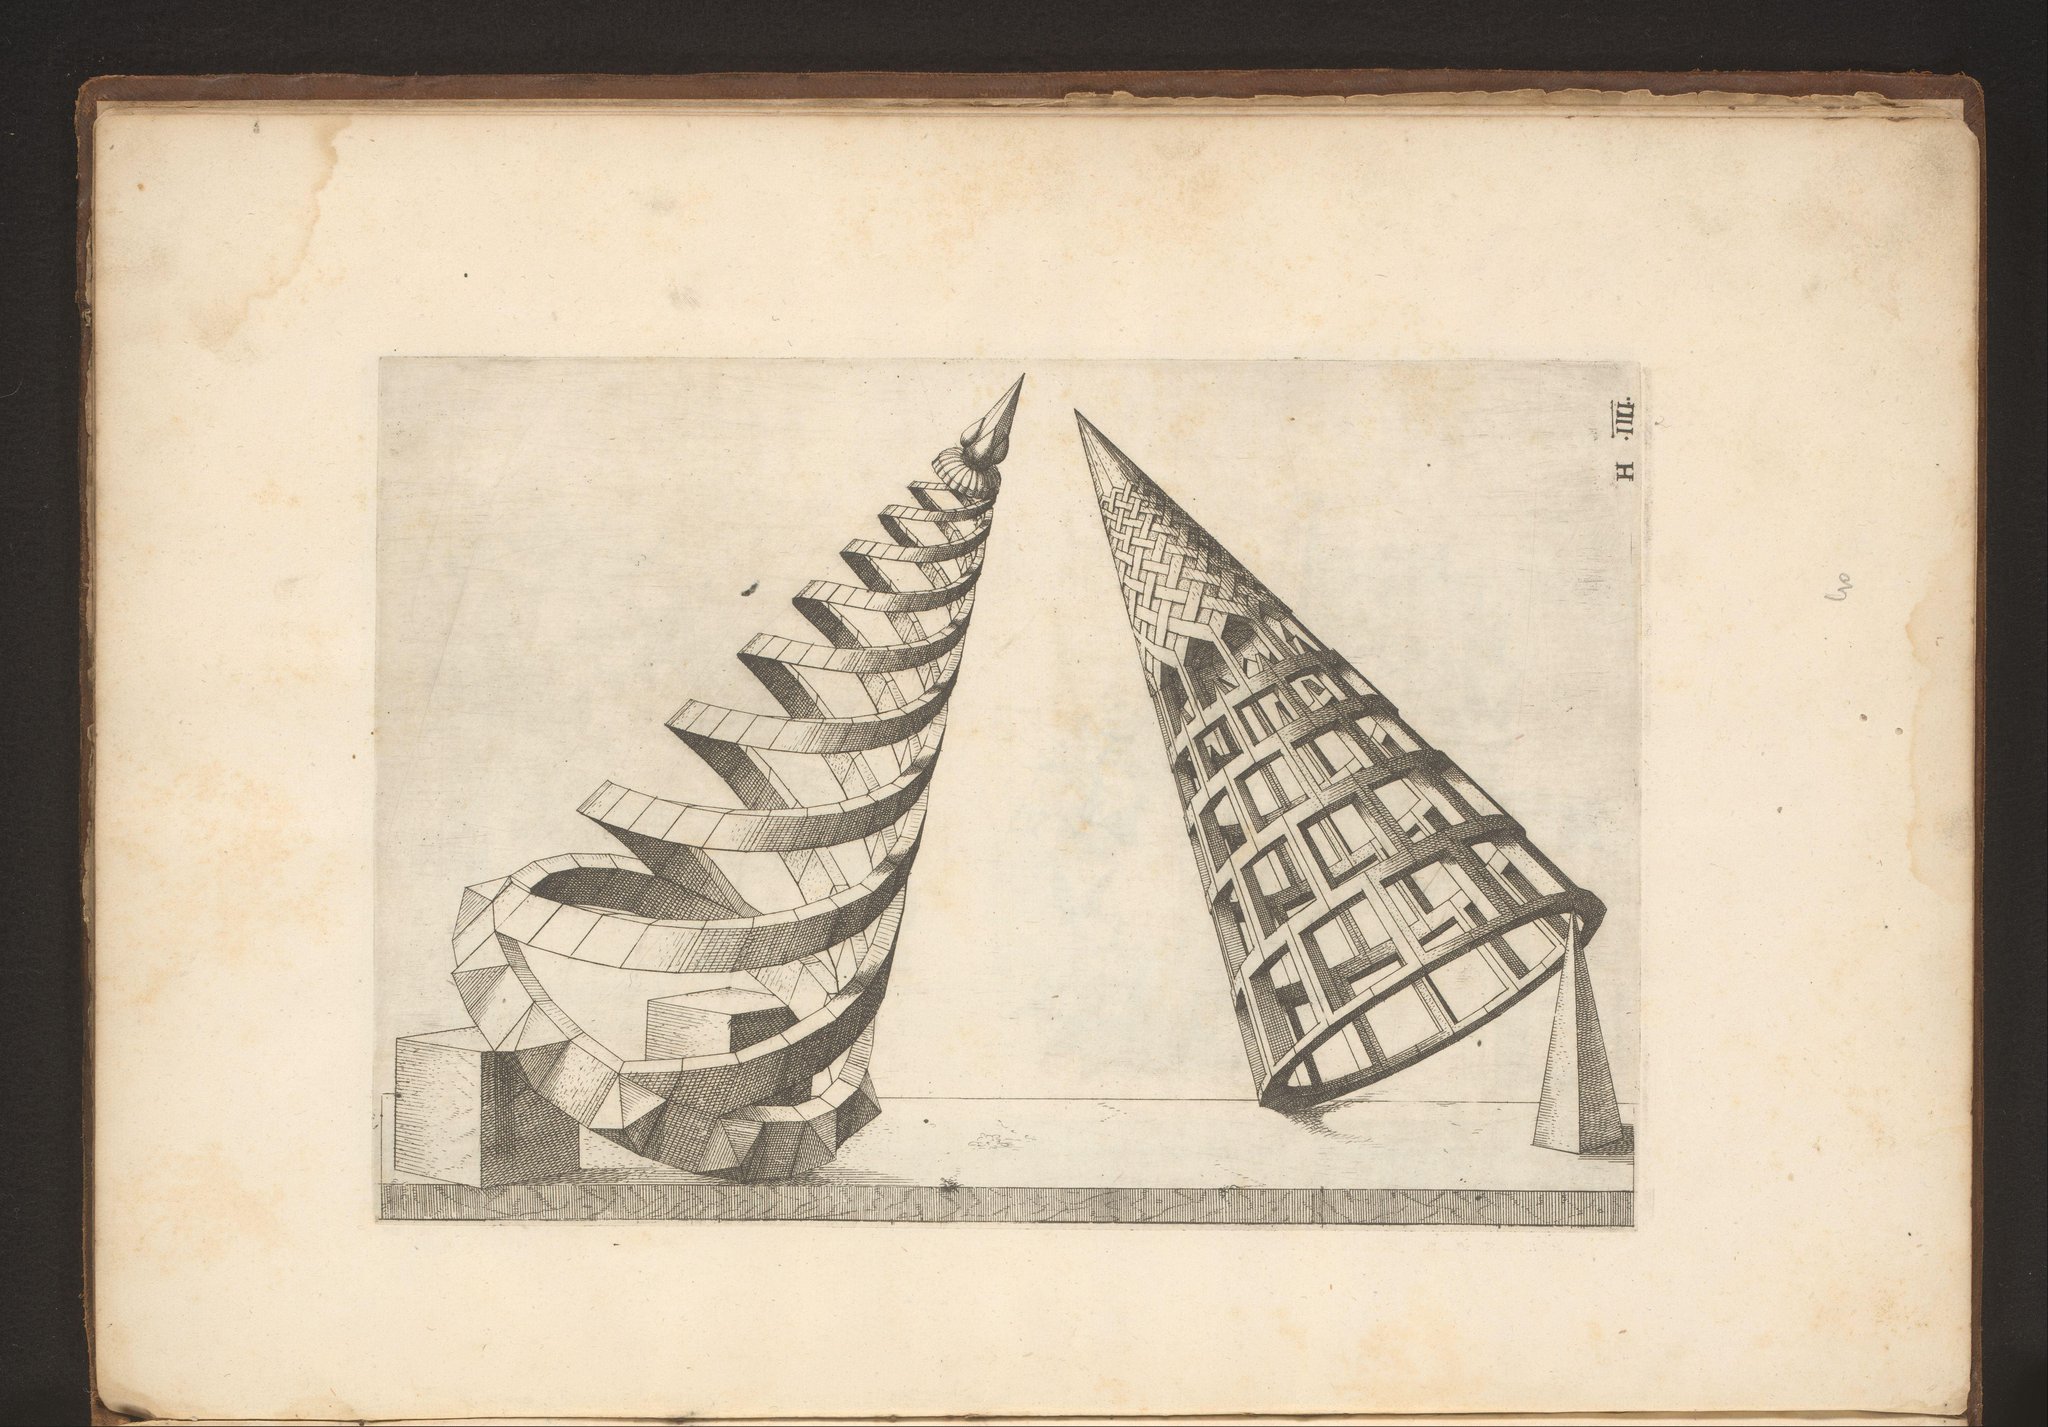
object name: print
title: Twee veelvlakken met een kegel als uitgangspunt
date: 1568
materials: paper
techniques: etching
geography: nuremberg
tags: other polyhedrons, cone ~ stereometry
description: Prent uit: Jamnitzer, Wenzel. Perspectiva corporum regularium (...). Neurenberg: Wenzel Jamnitzer, 1568.